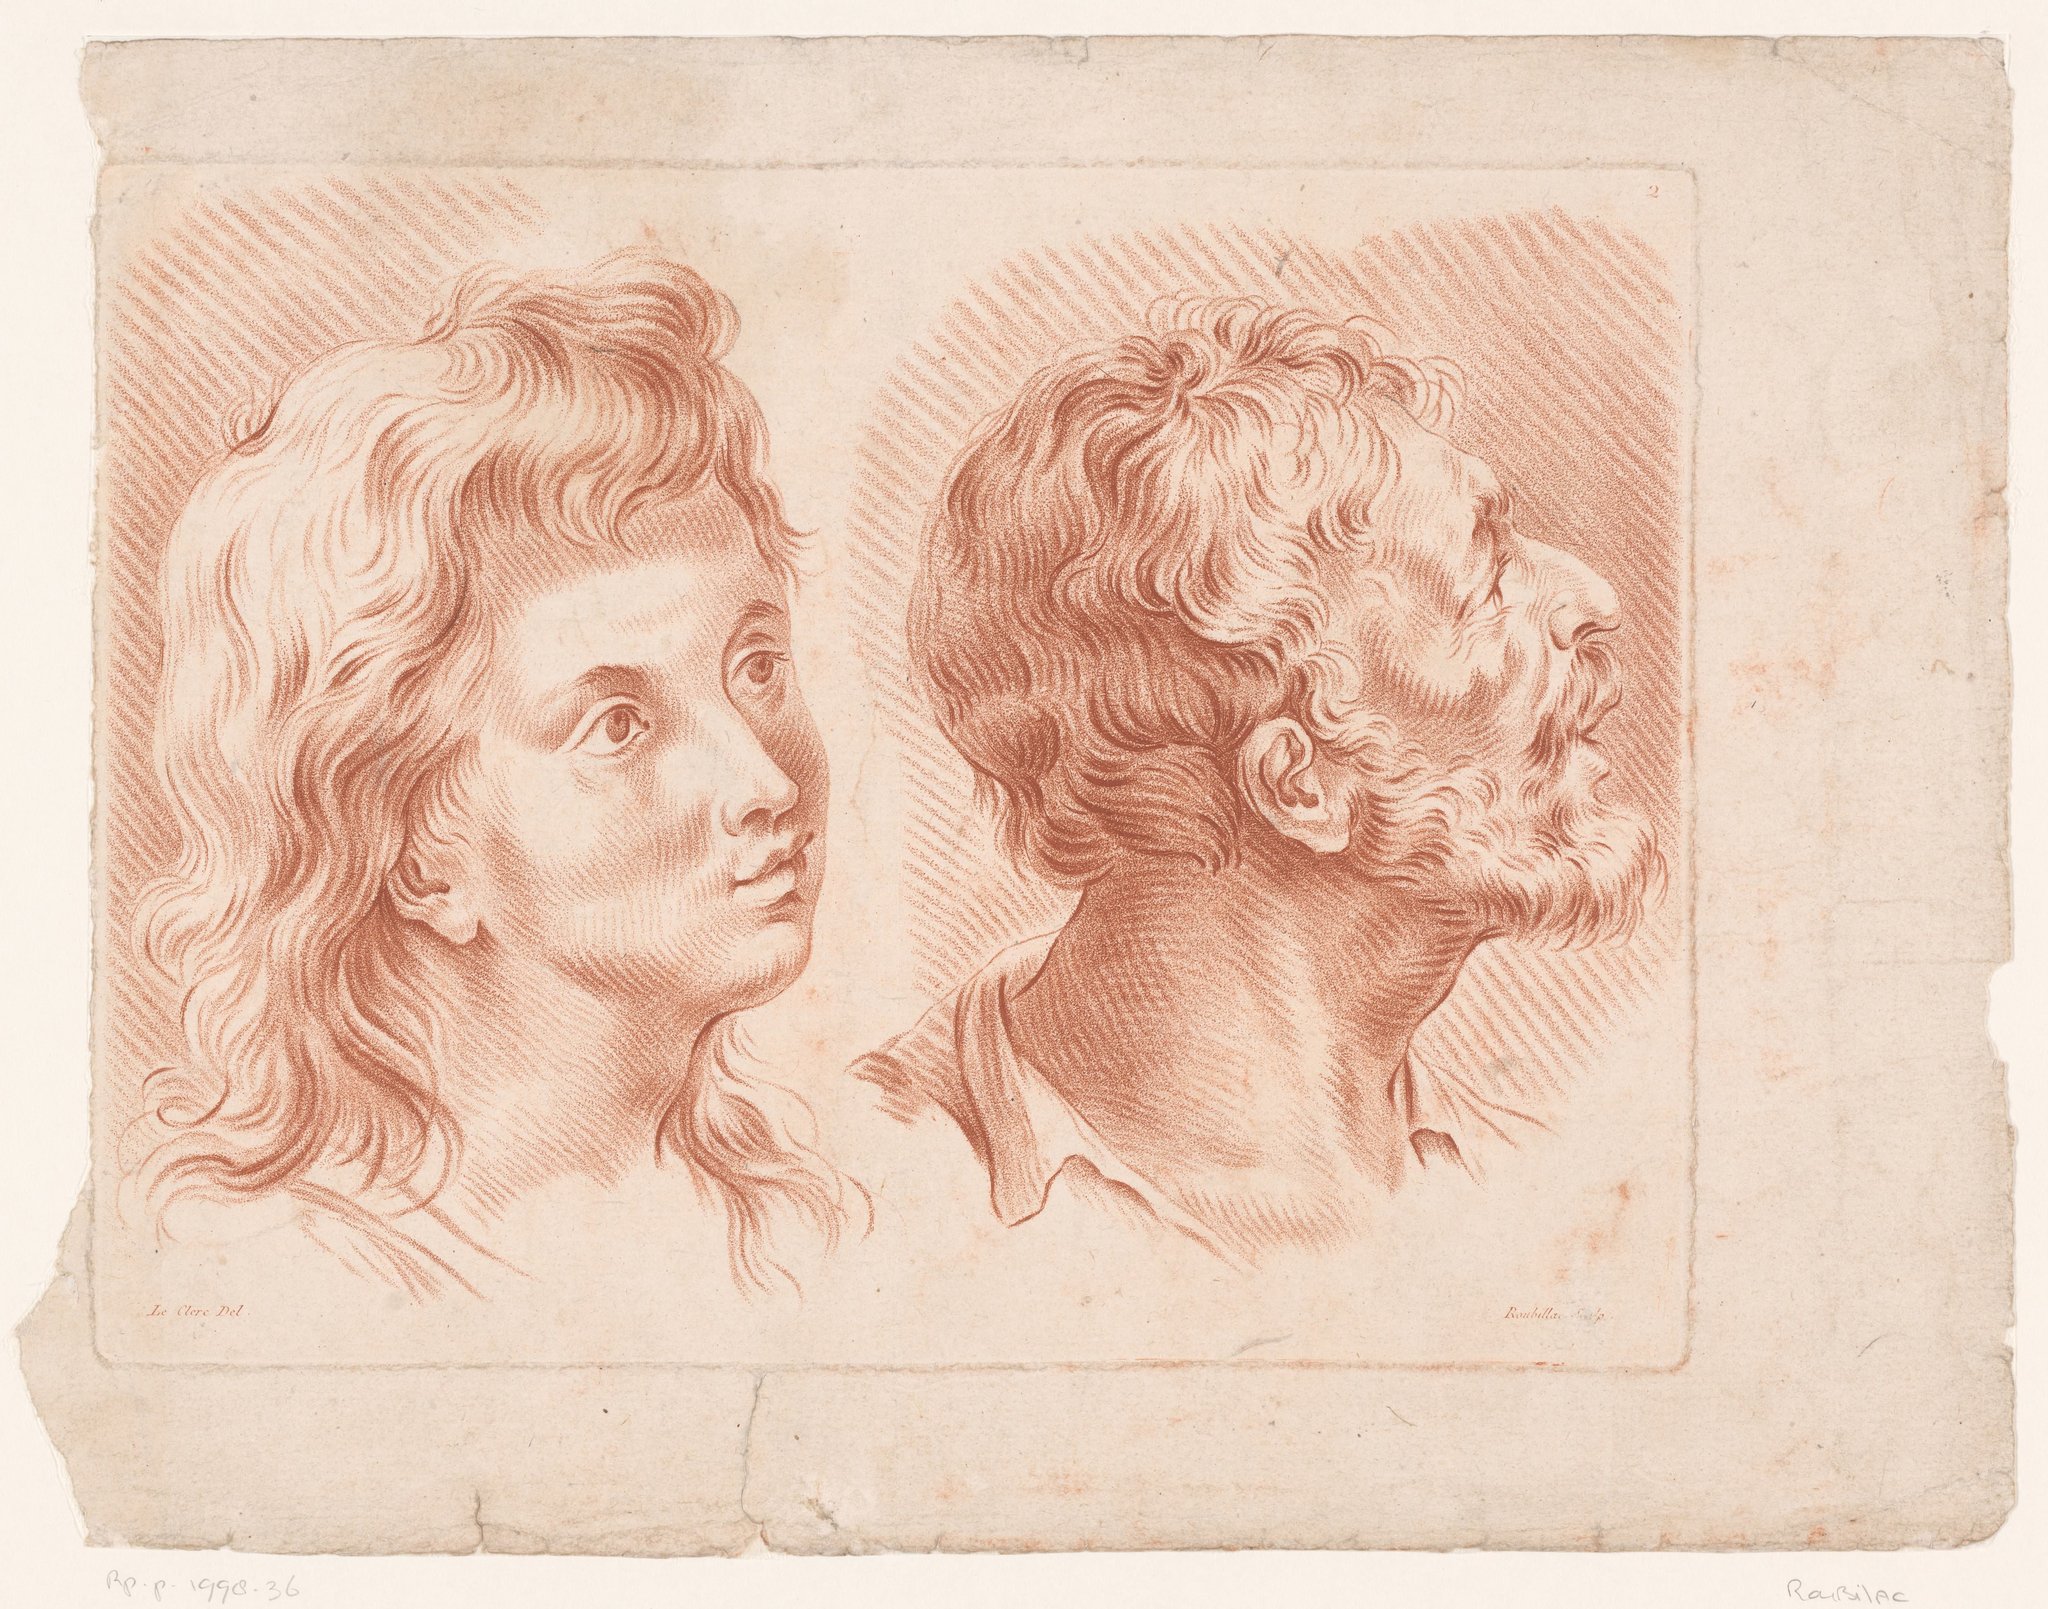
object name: print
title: Principes van het tekenen naar de natuur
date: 1749-1849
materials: paper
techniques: printmaking, etching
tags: drawing, sketch, head (human)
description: Onbekend tot welk deel van 'Principes du Dessin d'après Nature' deze prent behoort.